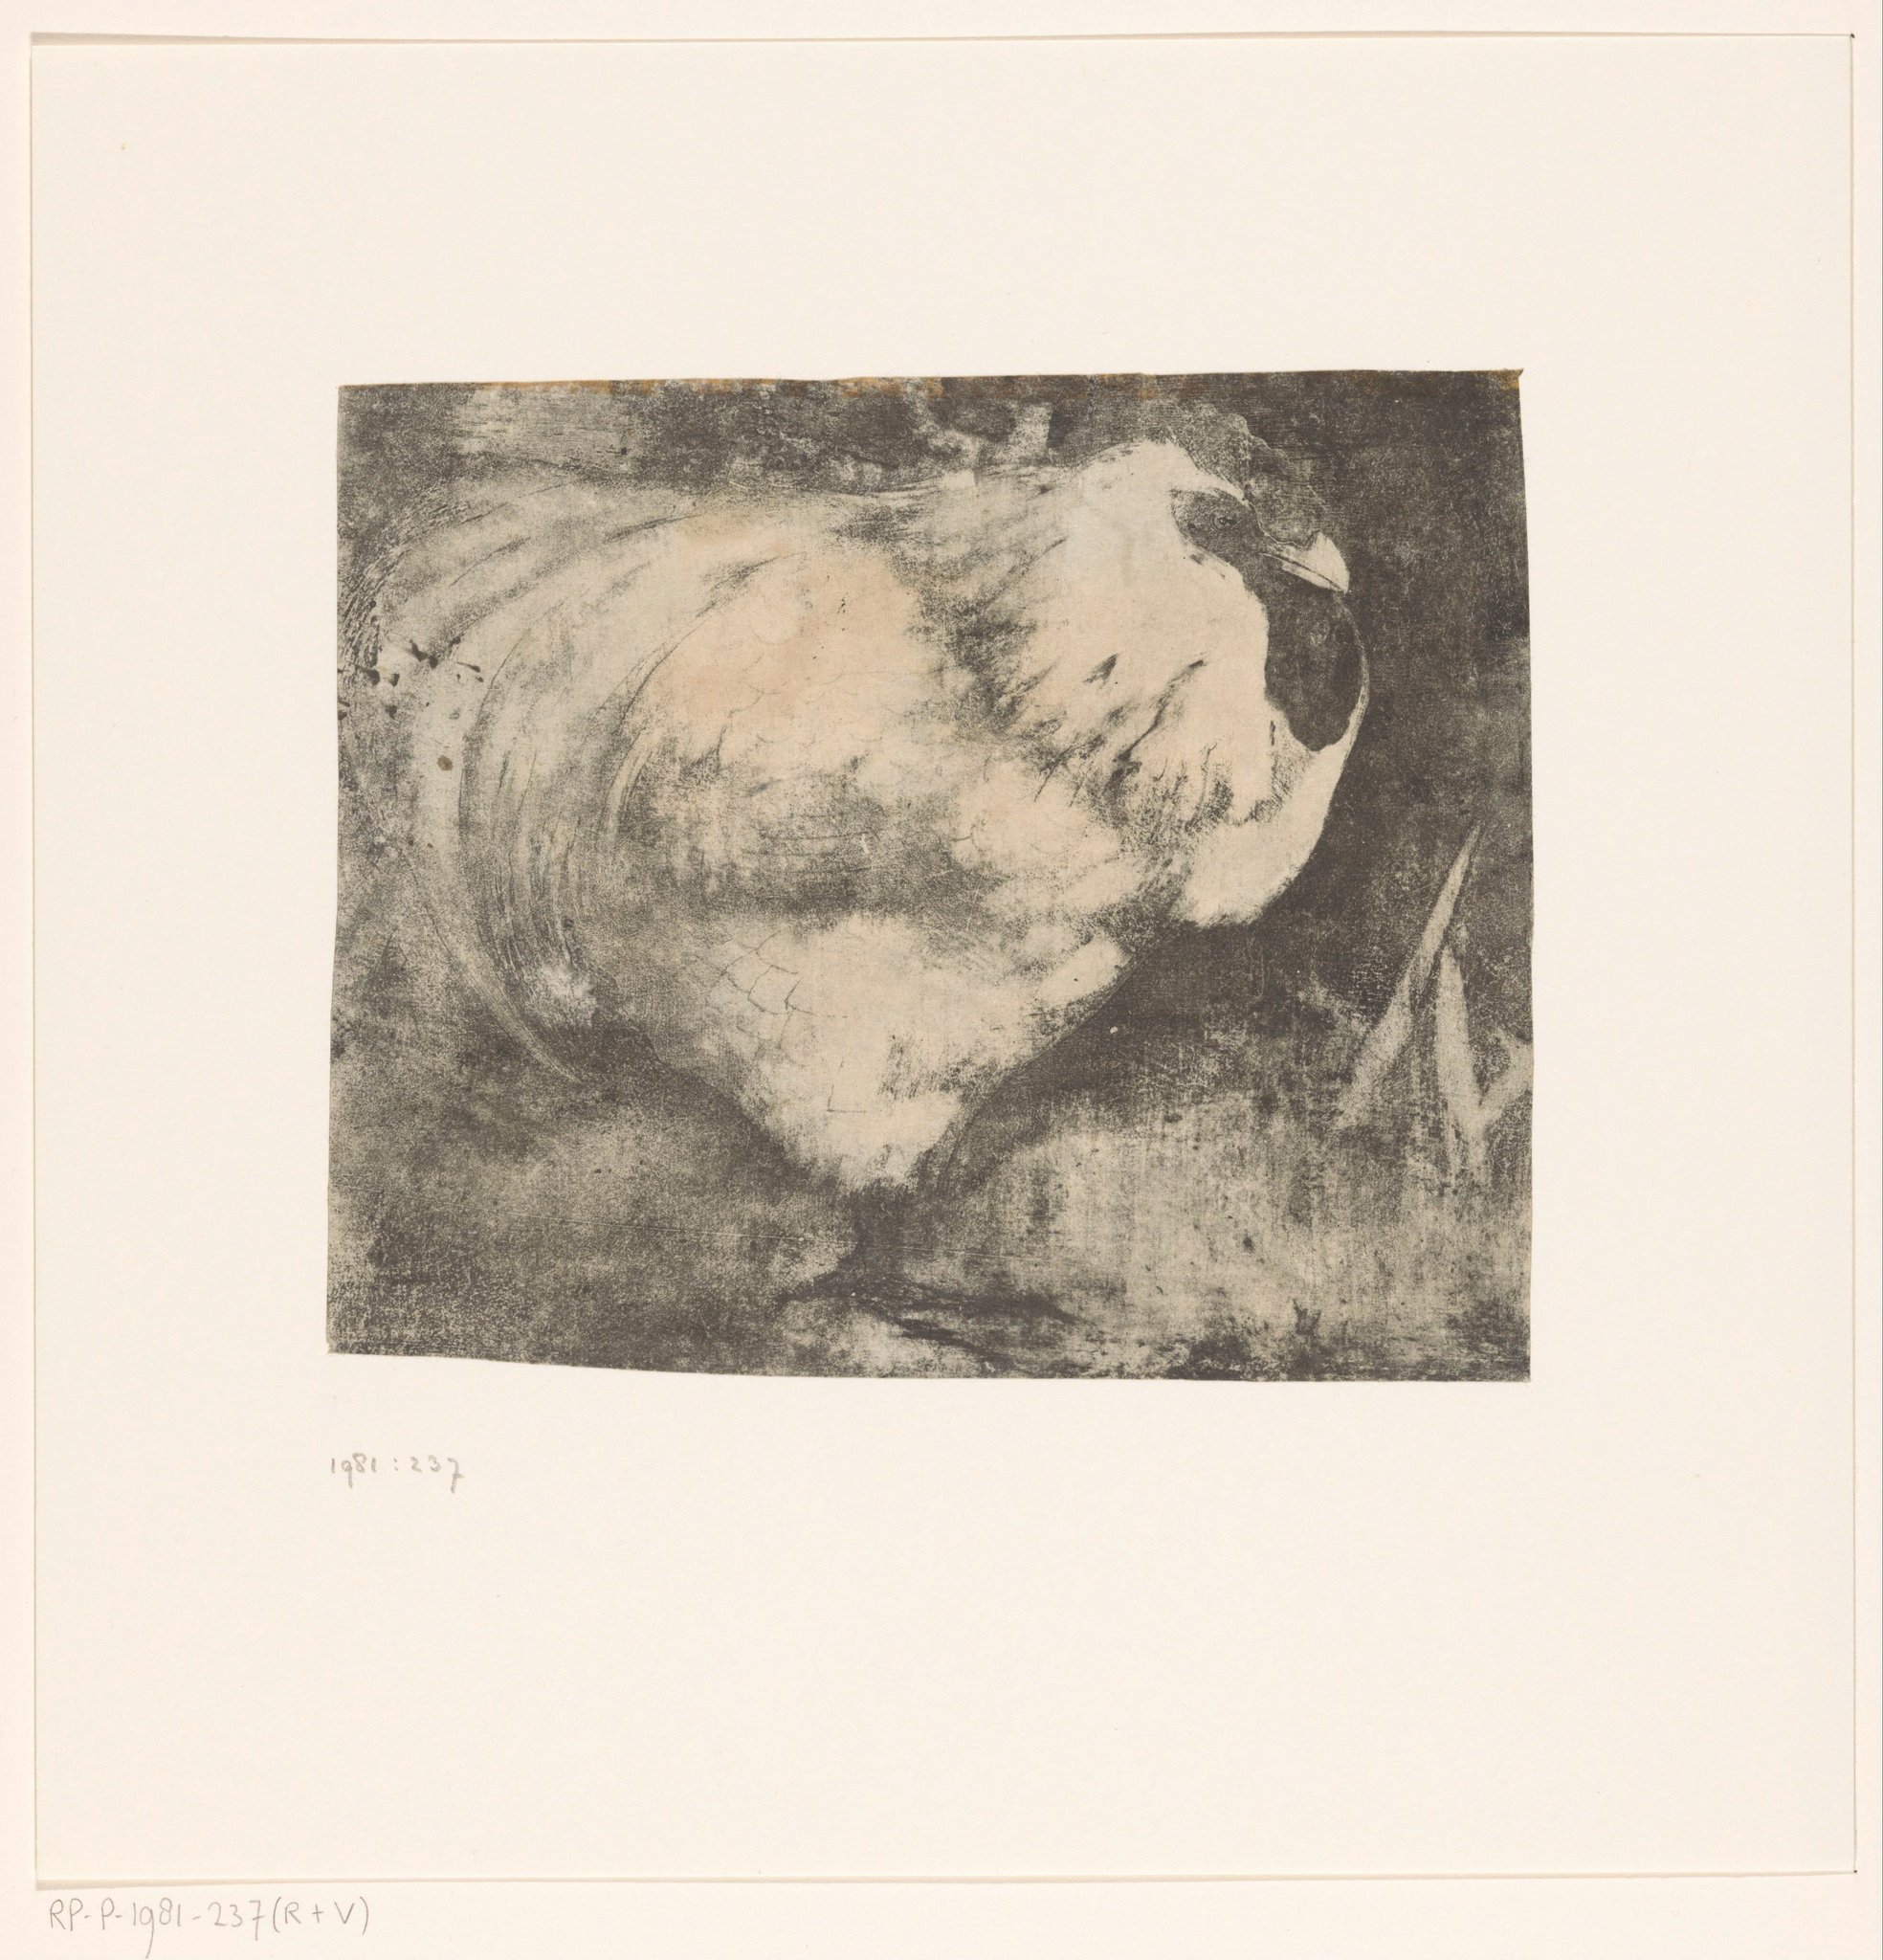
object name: print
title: Ineengedoken haan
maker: jan mankes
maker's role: draughtsman, painter, print maker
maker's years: 1889-1920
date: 1912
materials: paper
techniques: lithograph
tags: fowl (cock, hen, chicken, etc.)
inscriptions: collector's mark: Lugt 2228